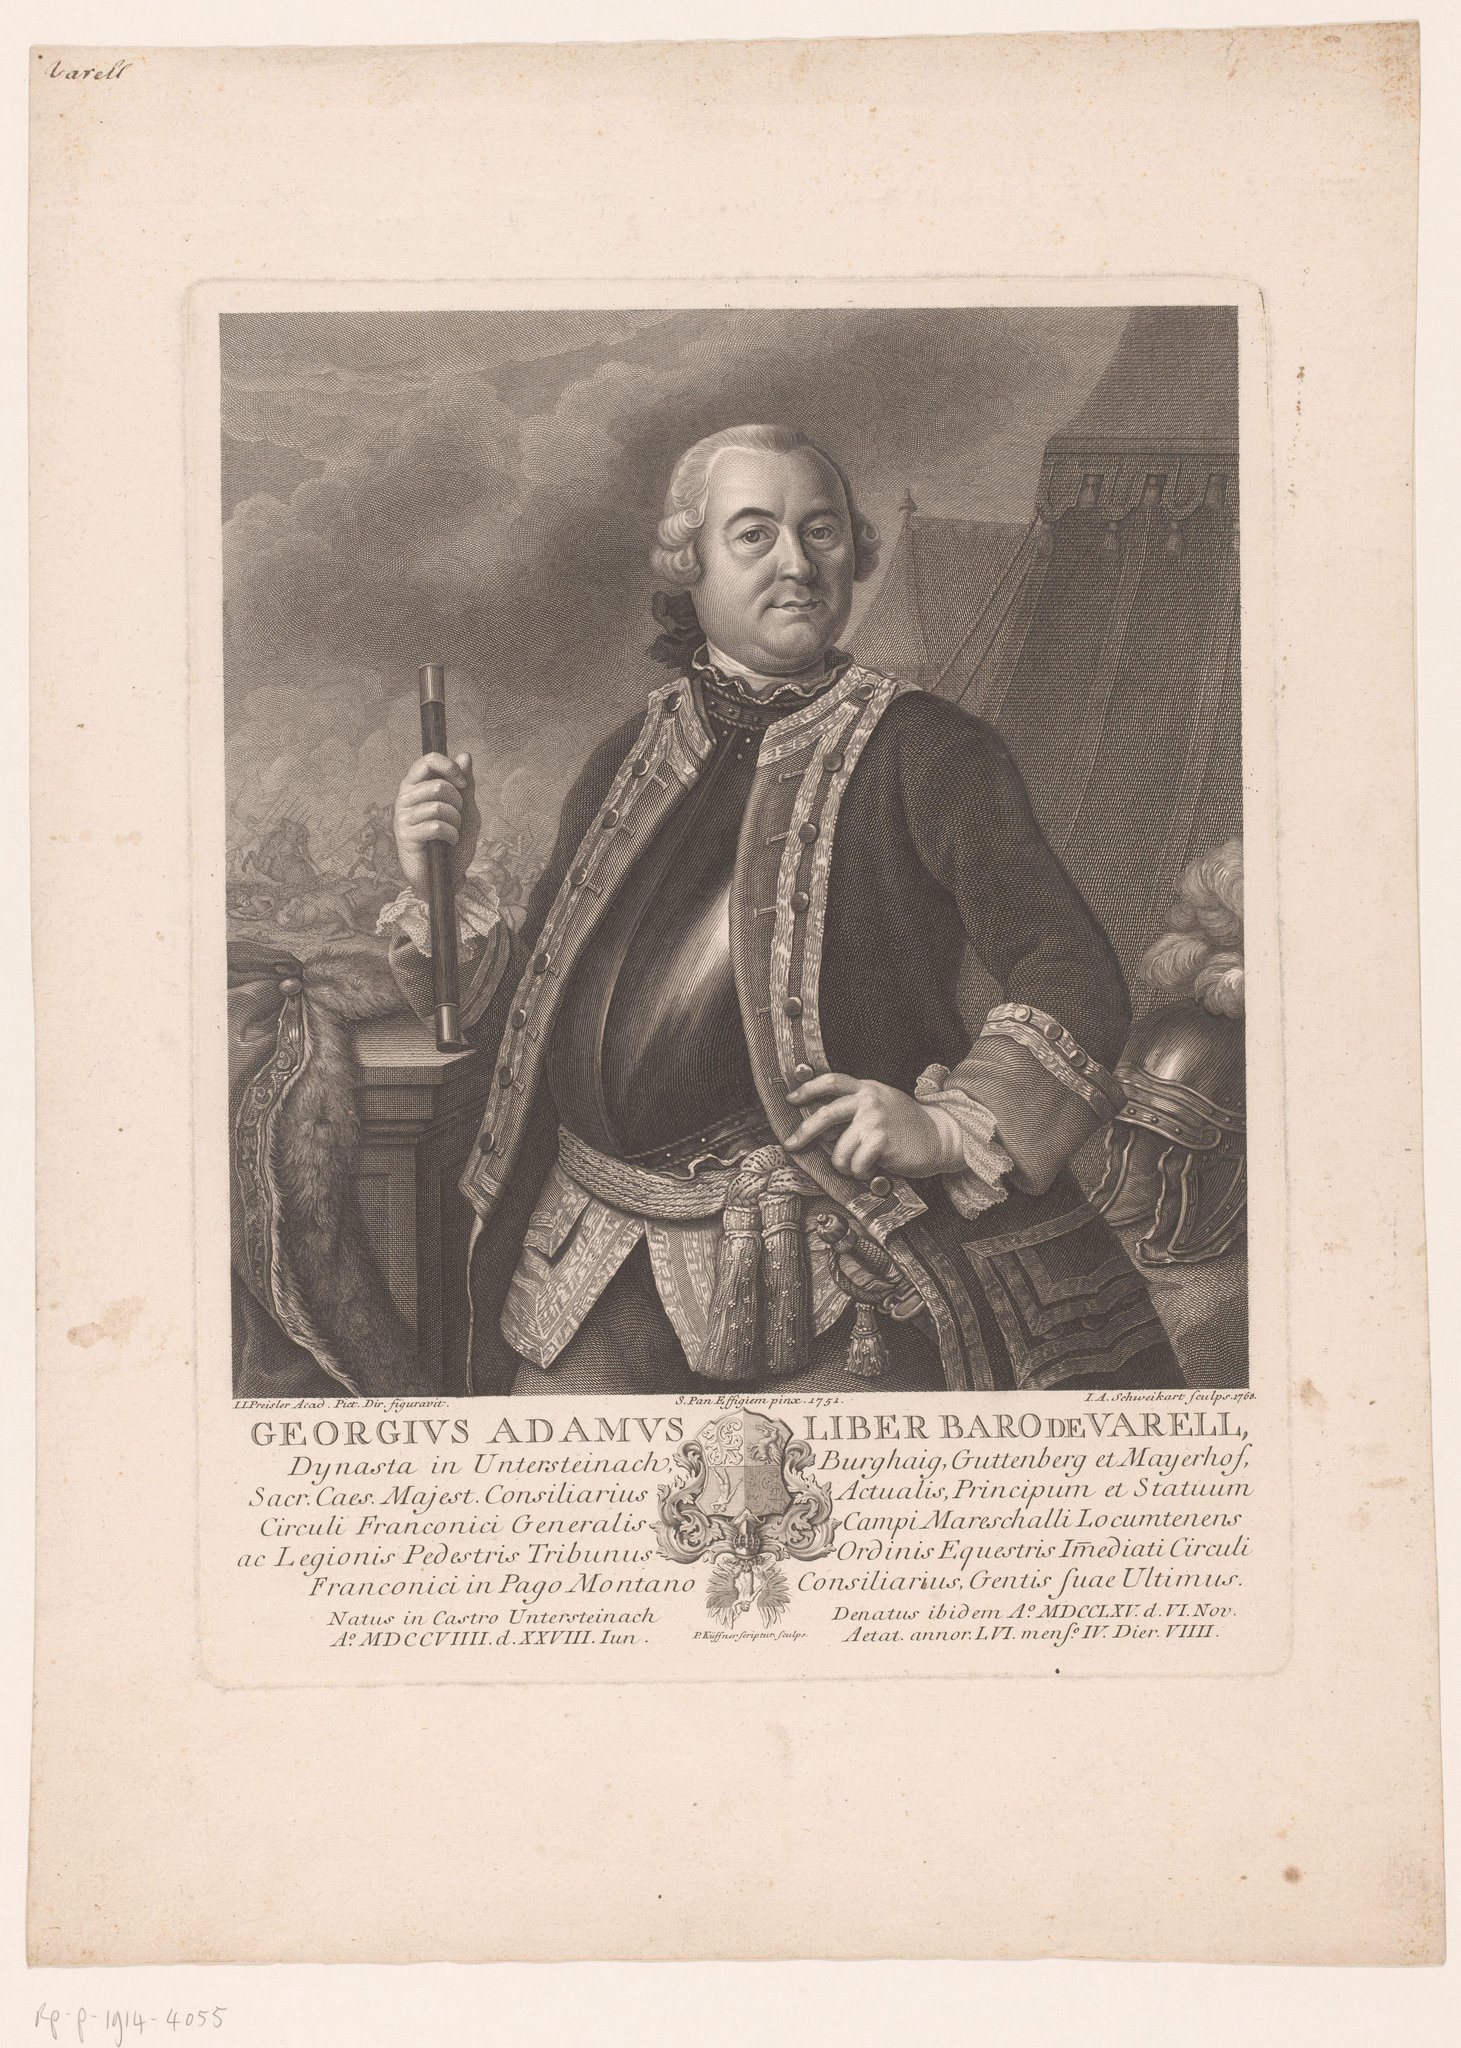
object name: print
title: Portret van Georg Adam, Freiherr von Varell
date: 1768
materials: paper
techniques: engraving, etching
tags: historical persons, symbols, allegories of war; 'guerra' (ripa), armorial bearing, heraldry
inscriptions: collector's mark: Lugt 2228